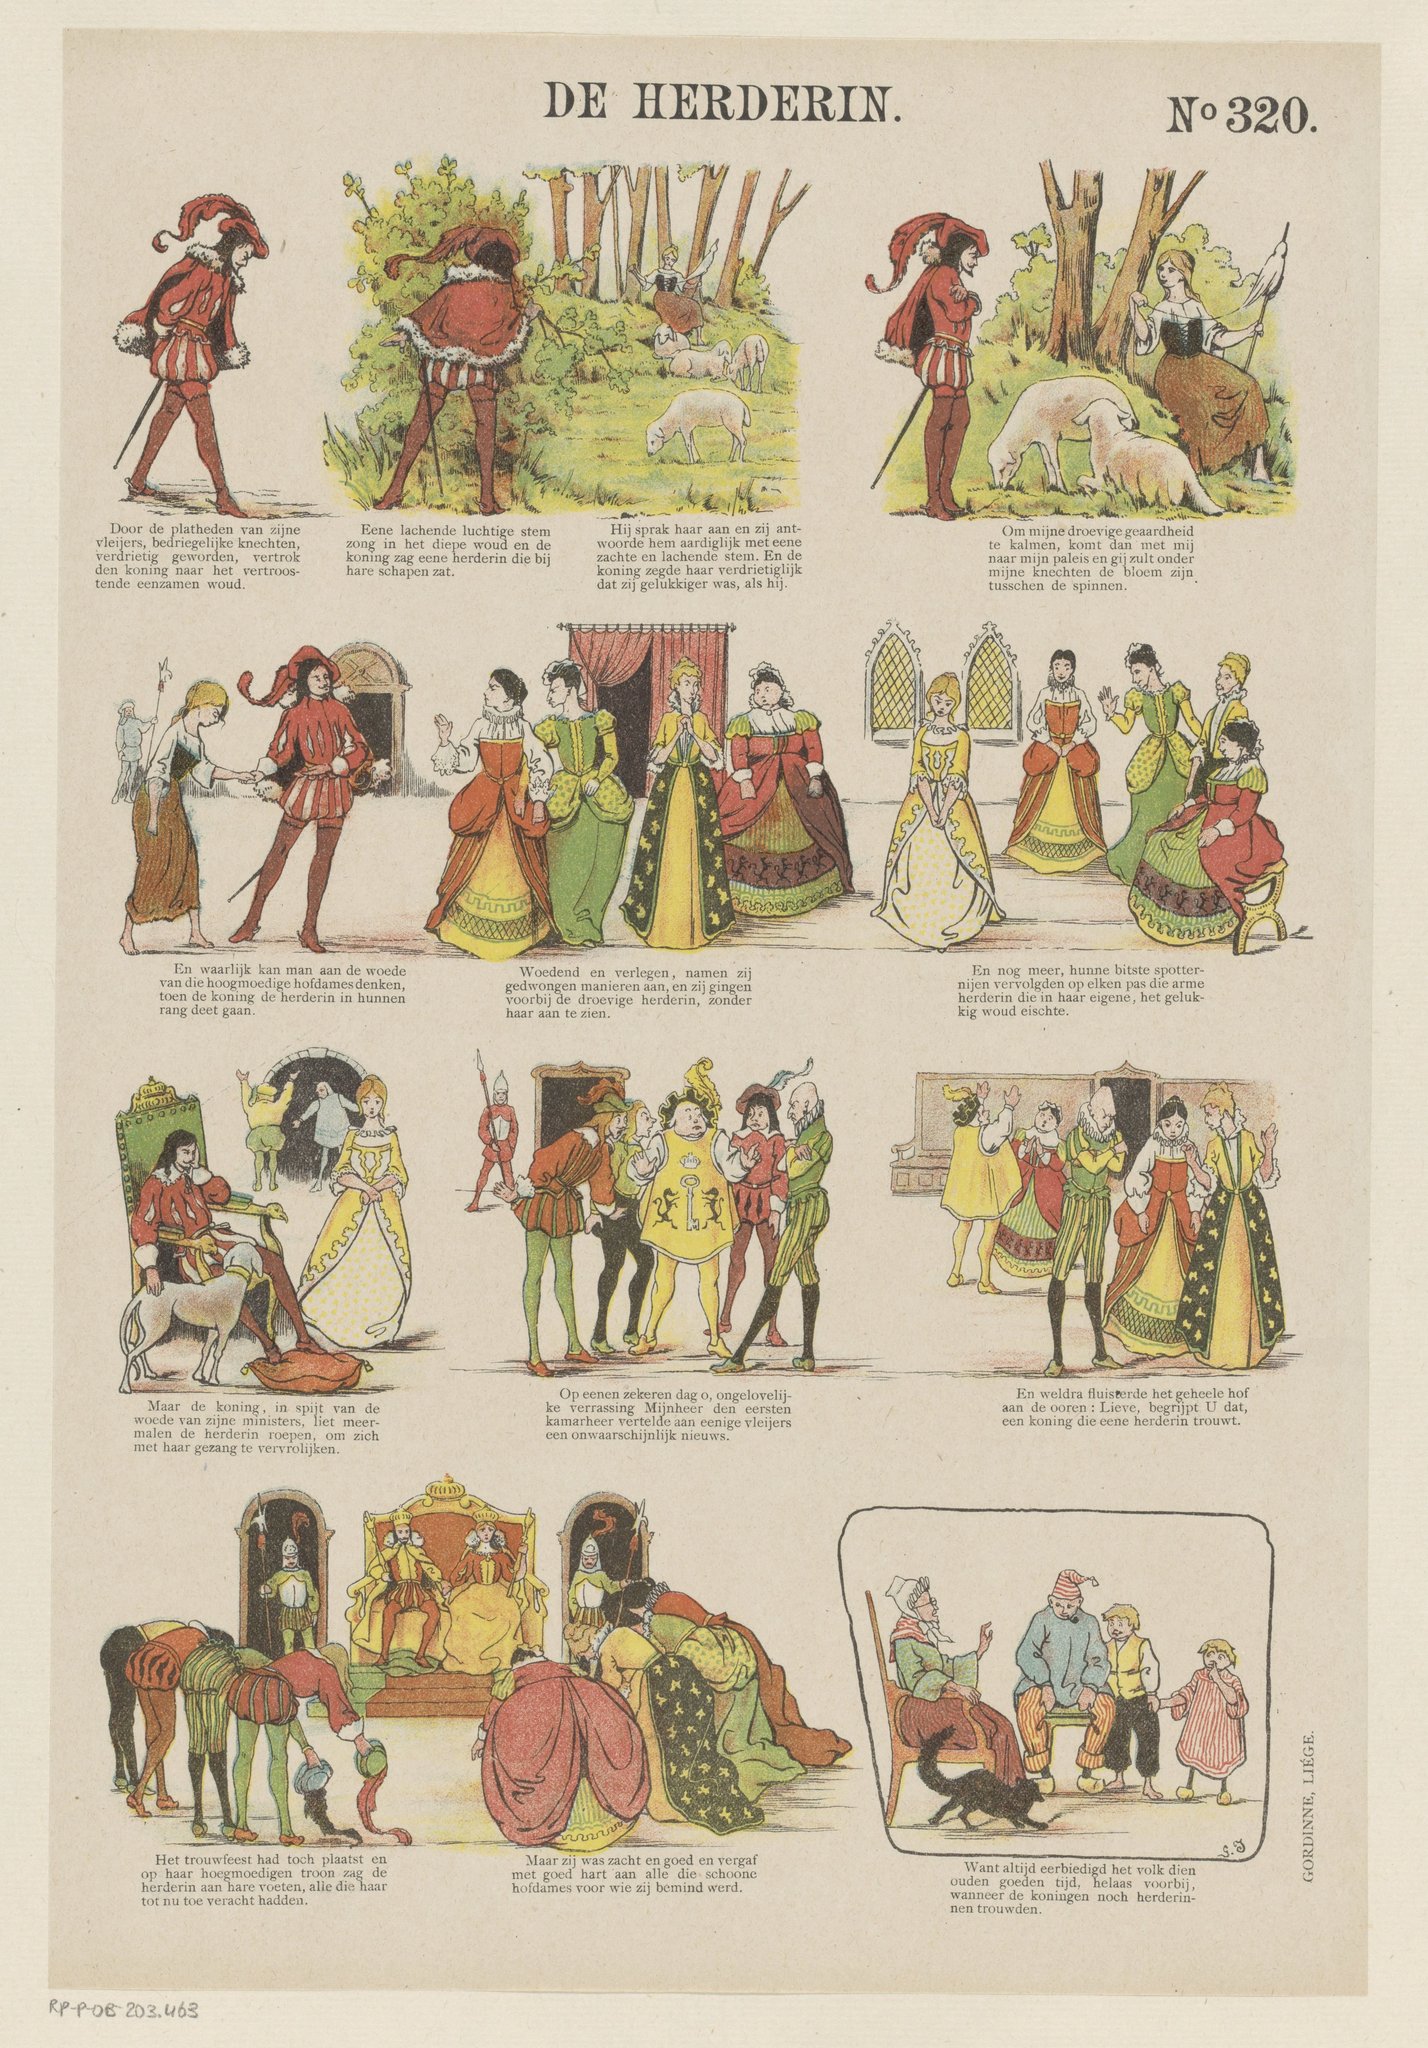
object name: print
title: De herderin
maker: Anonymous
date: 1894-1959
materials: paper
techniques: lithograph, letterpress printing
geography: liège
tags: herding, herdsman, herdswoman, shepherd, shepherdess, cowherd, etc., ruler, sovereign - bb - female ruler, ruler, sovereign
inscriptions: collector's mark: Lugt 2760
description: Blad met 11 voorstellingen over een koning die trouwt met een herderin. Onder elke afbeelding een onderschrift. Genummerd rechtsboven: No 320.